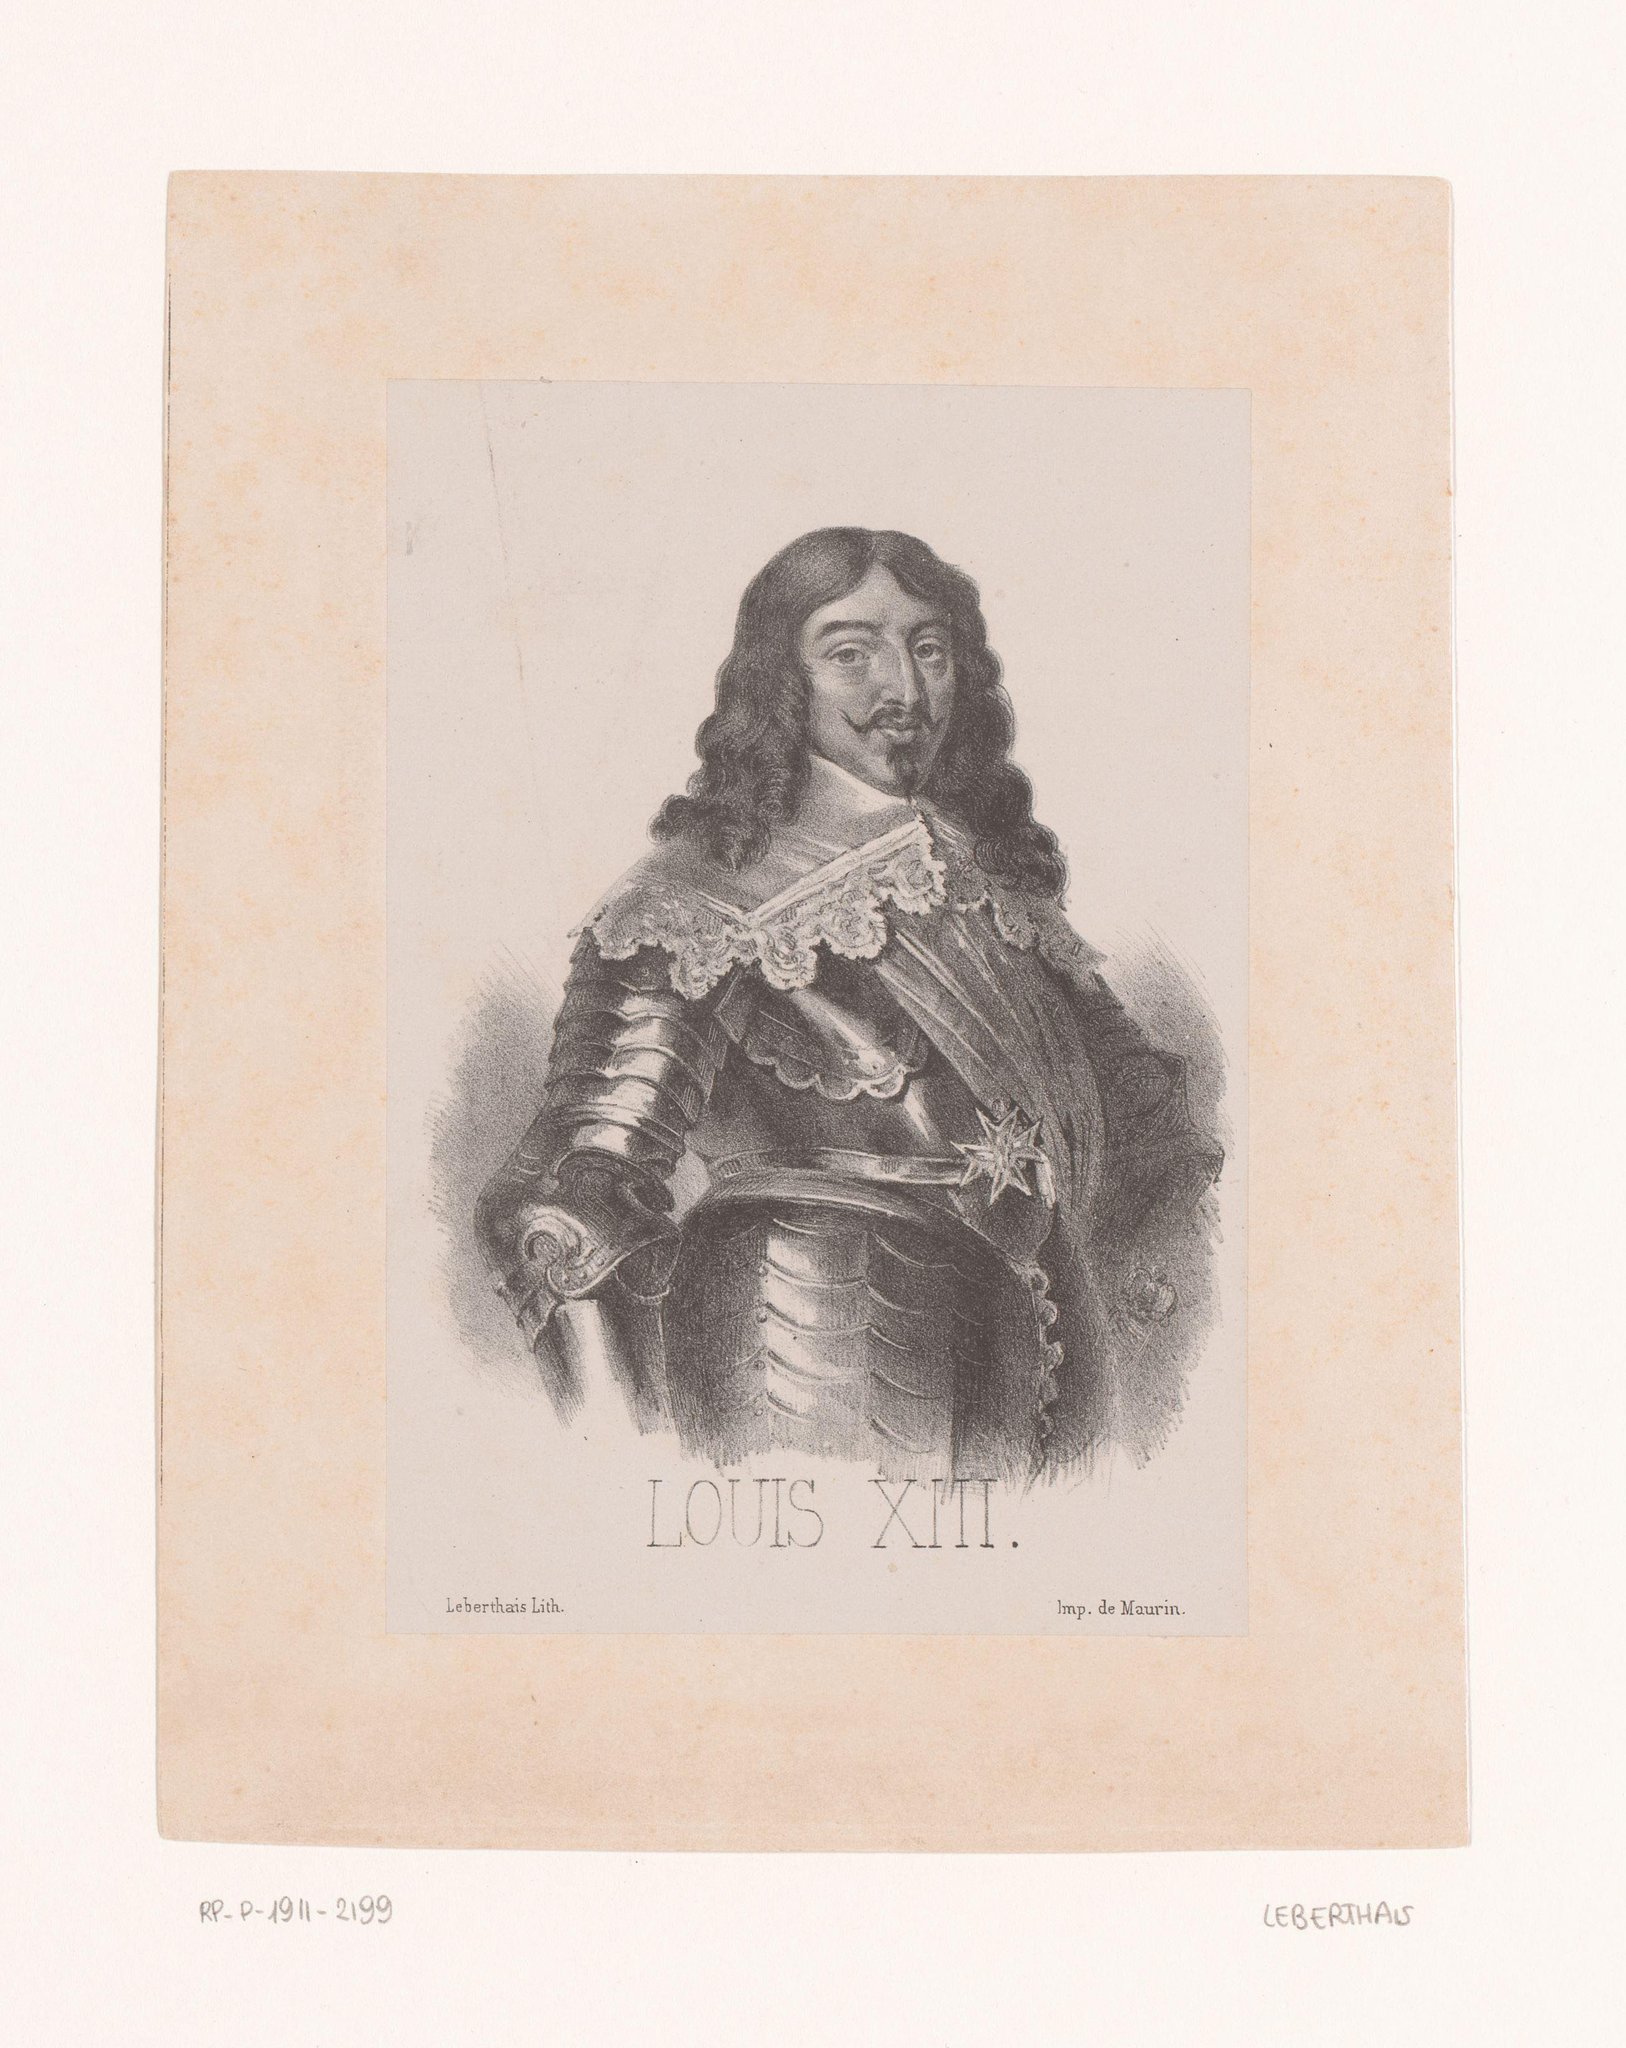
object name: print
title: Portret van Lodewijk XIII van Frankrijk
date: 1836-1865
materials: paper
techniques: lithograph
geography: paris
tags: lodewijk xiii (koning van frankrijk), historical persons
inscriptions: collector's mark: Lugt 2228a